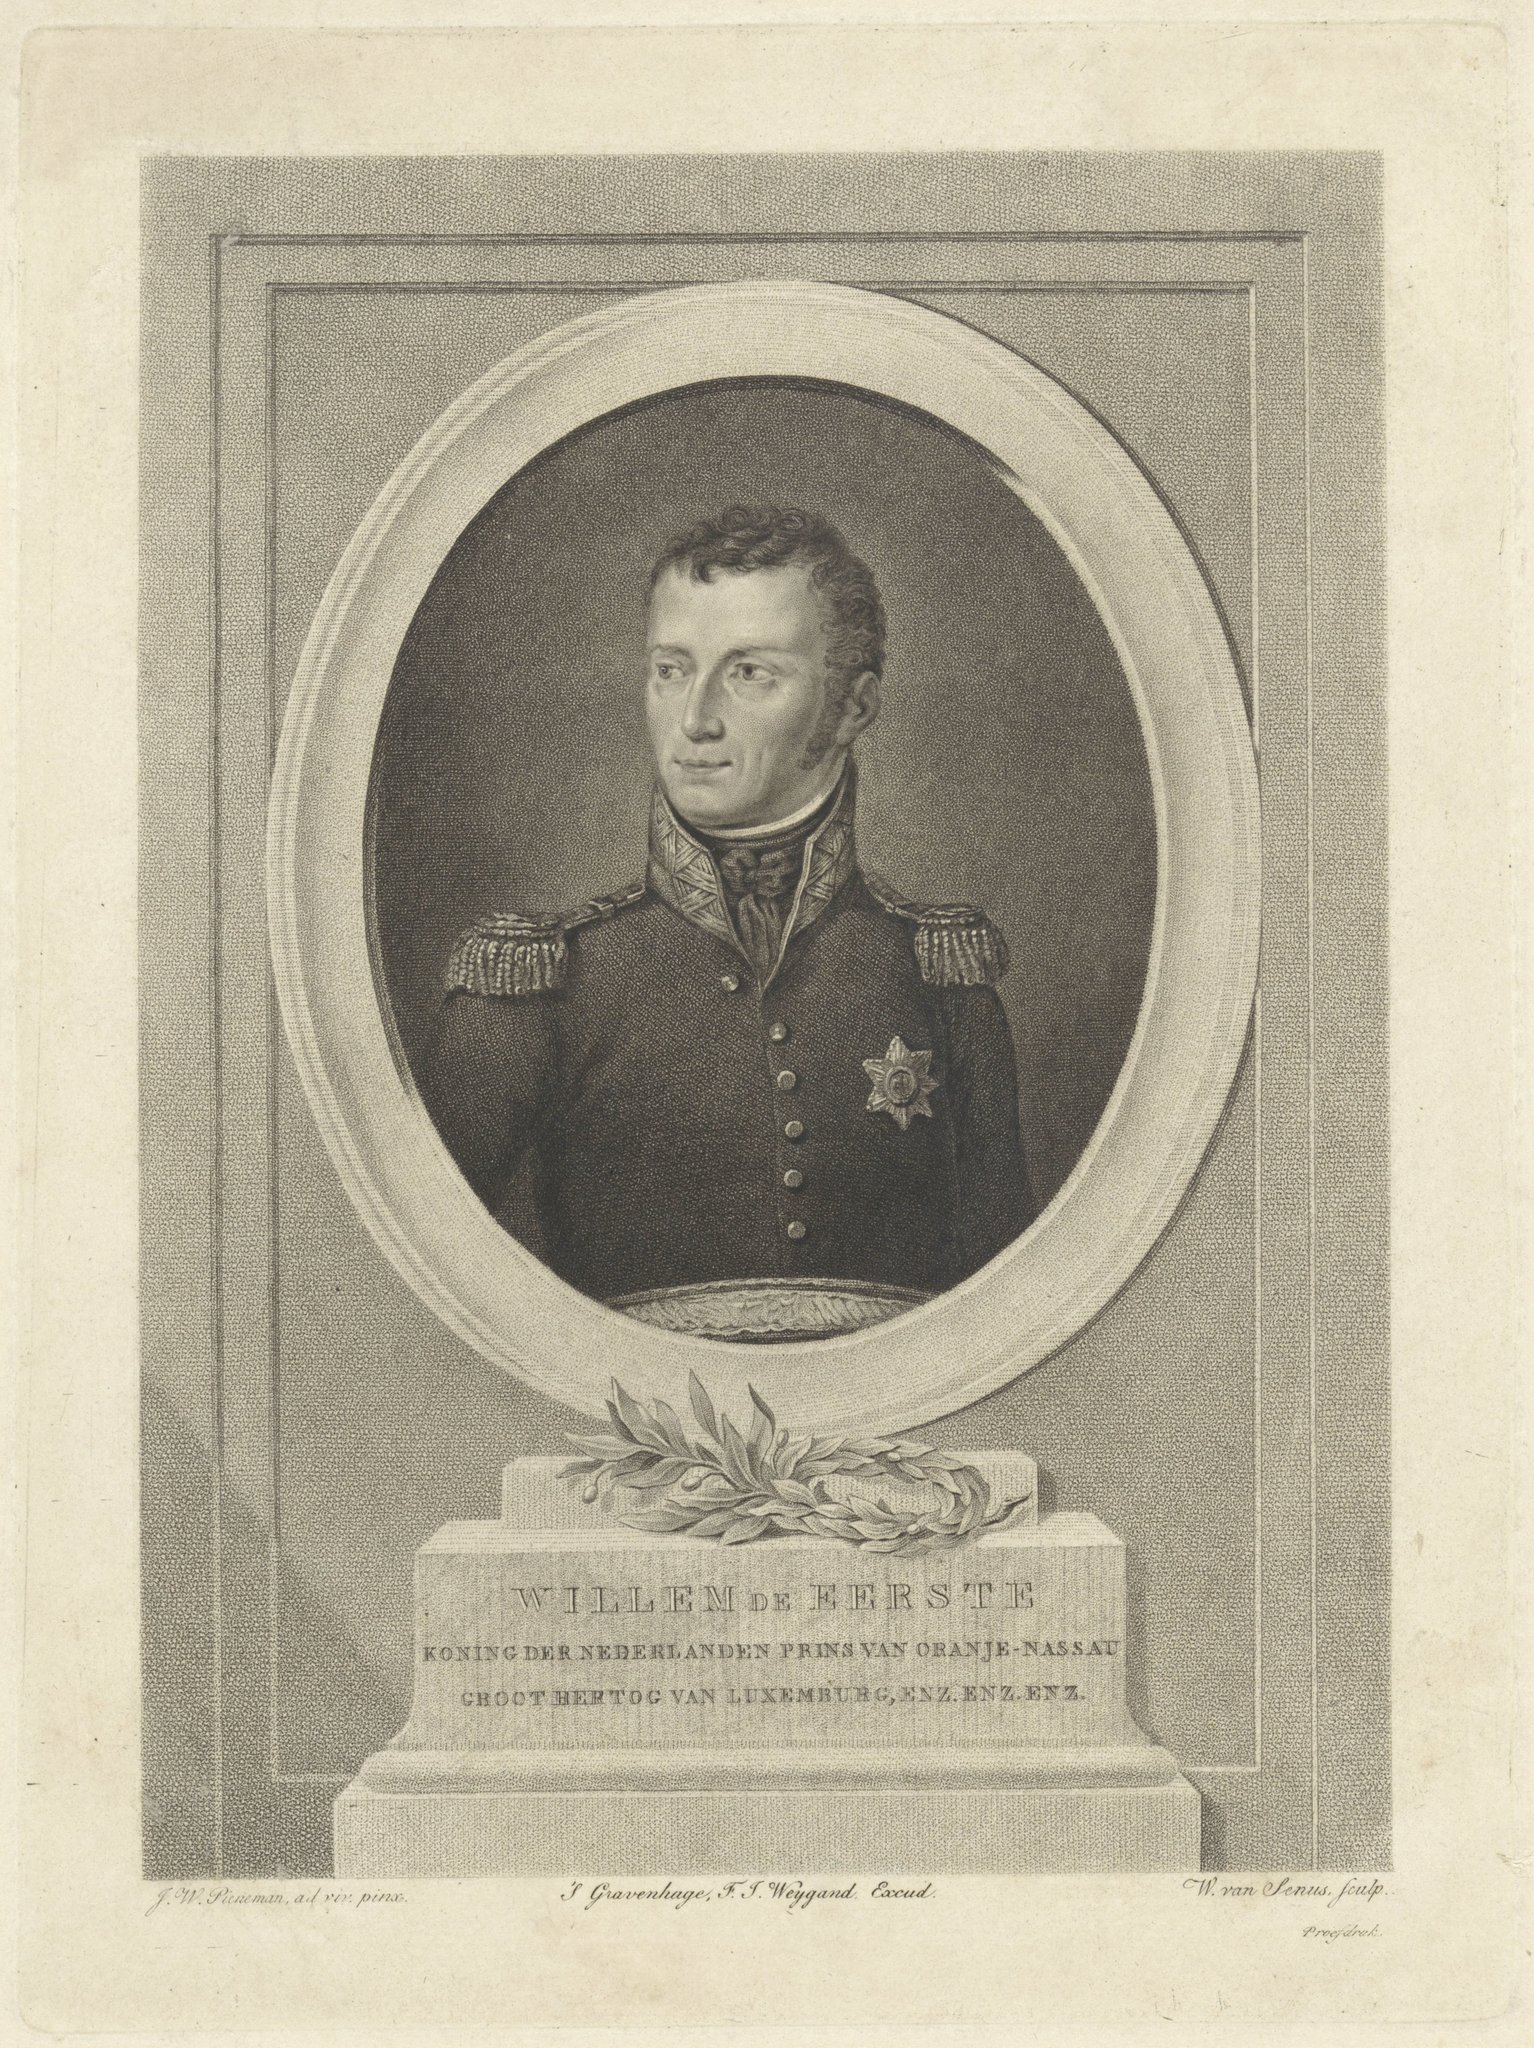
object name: print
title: Portret van Willem I Frederik (koning der Nederlanden)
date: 1814-1843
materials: paper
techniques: engraving, etching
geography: the hague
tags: the hague, berlin, william i of the netherlands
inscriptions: collector's mark: Lugt 2228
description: Portret van Willem I Frederik (koning der Nederlanden), in een medaillon op een piëdestal, waarop twee lauwerkransen.